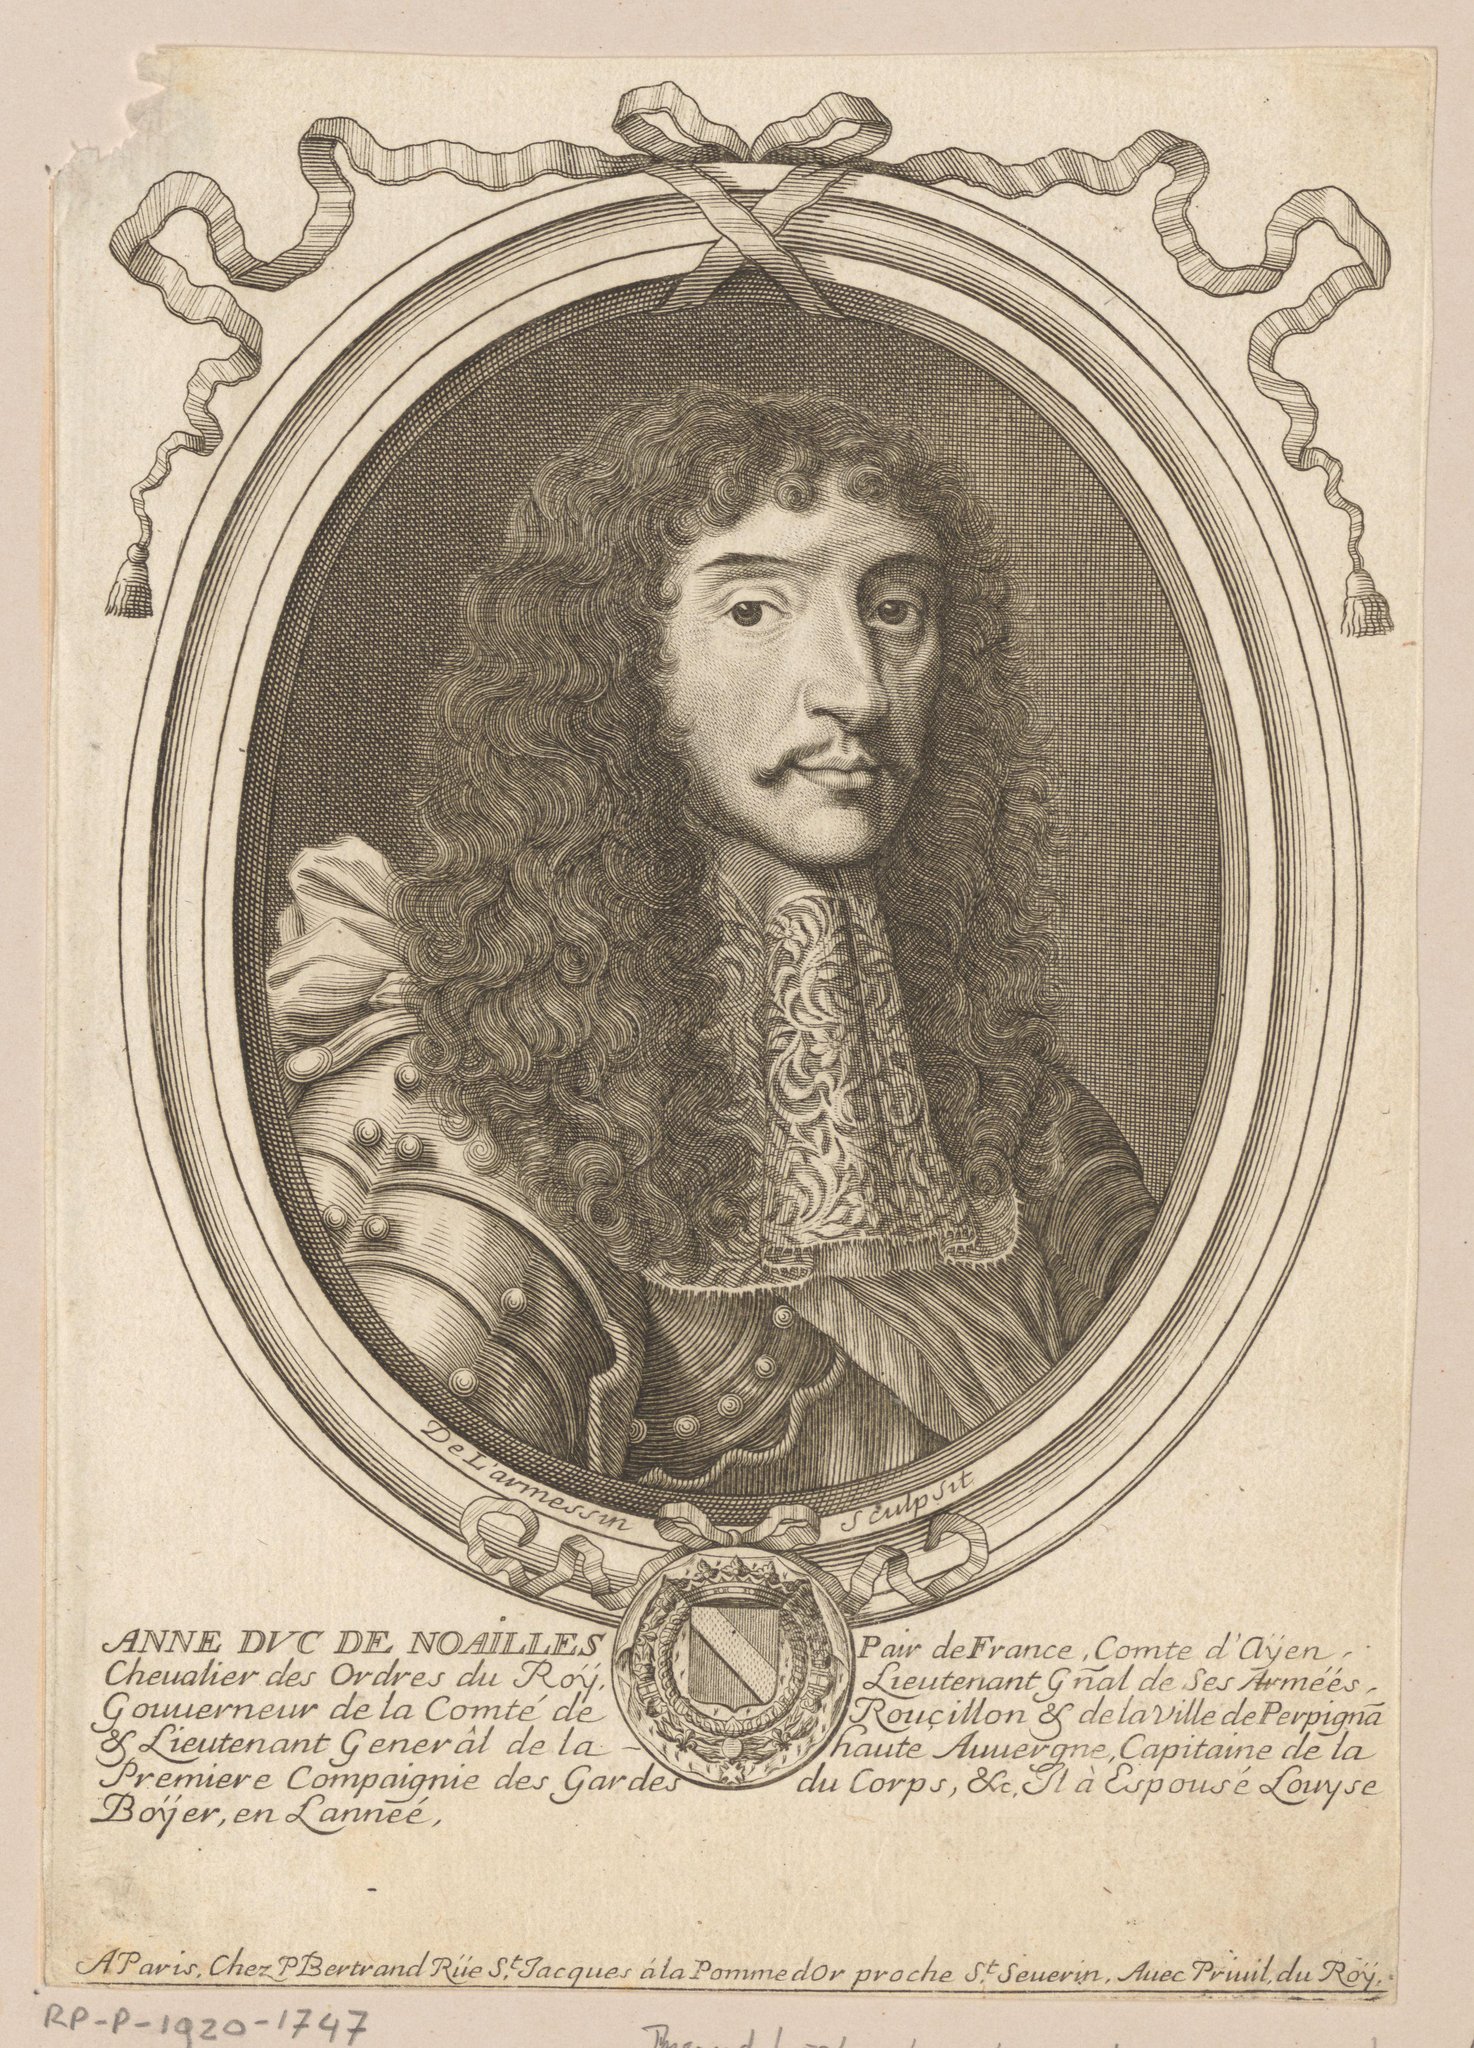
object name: print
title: Portret van Anne Jules hertog van Noailles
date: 1642-1678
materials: paper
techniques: engraving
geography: paris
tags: anne jules hertog van noailles, commander-in-chief, general, marshal, historical persons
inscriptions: collector's mark: Lugt 2228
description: Uit een serie van minstens 240 portretten, eerst gepubliceerd door Pierre Bertrand, daarna door zijn weduwe en daarna door De Larmessin zelf.